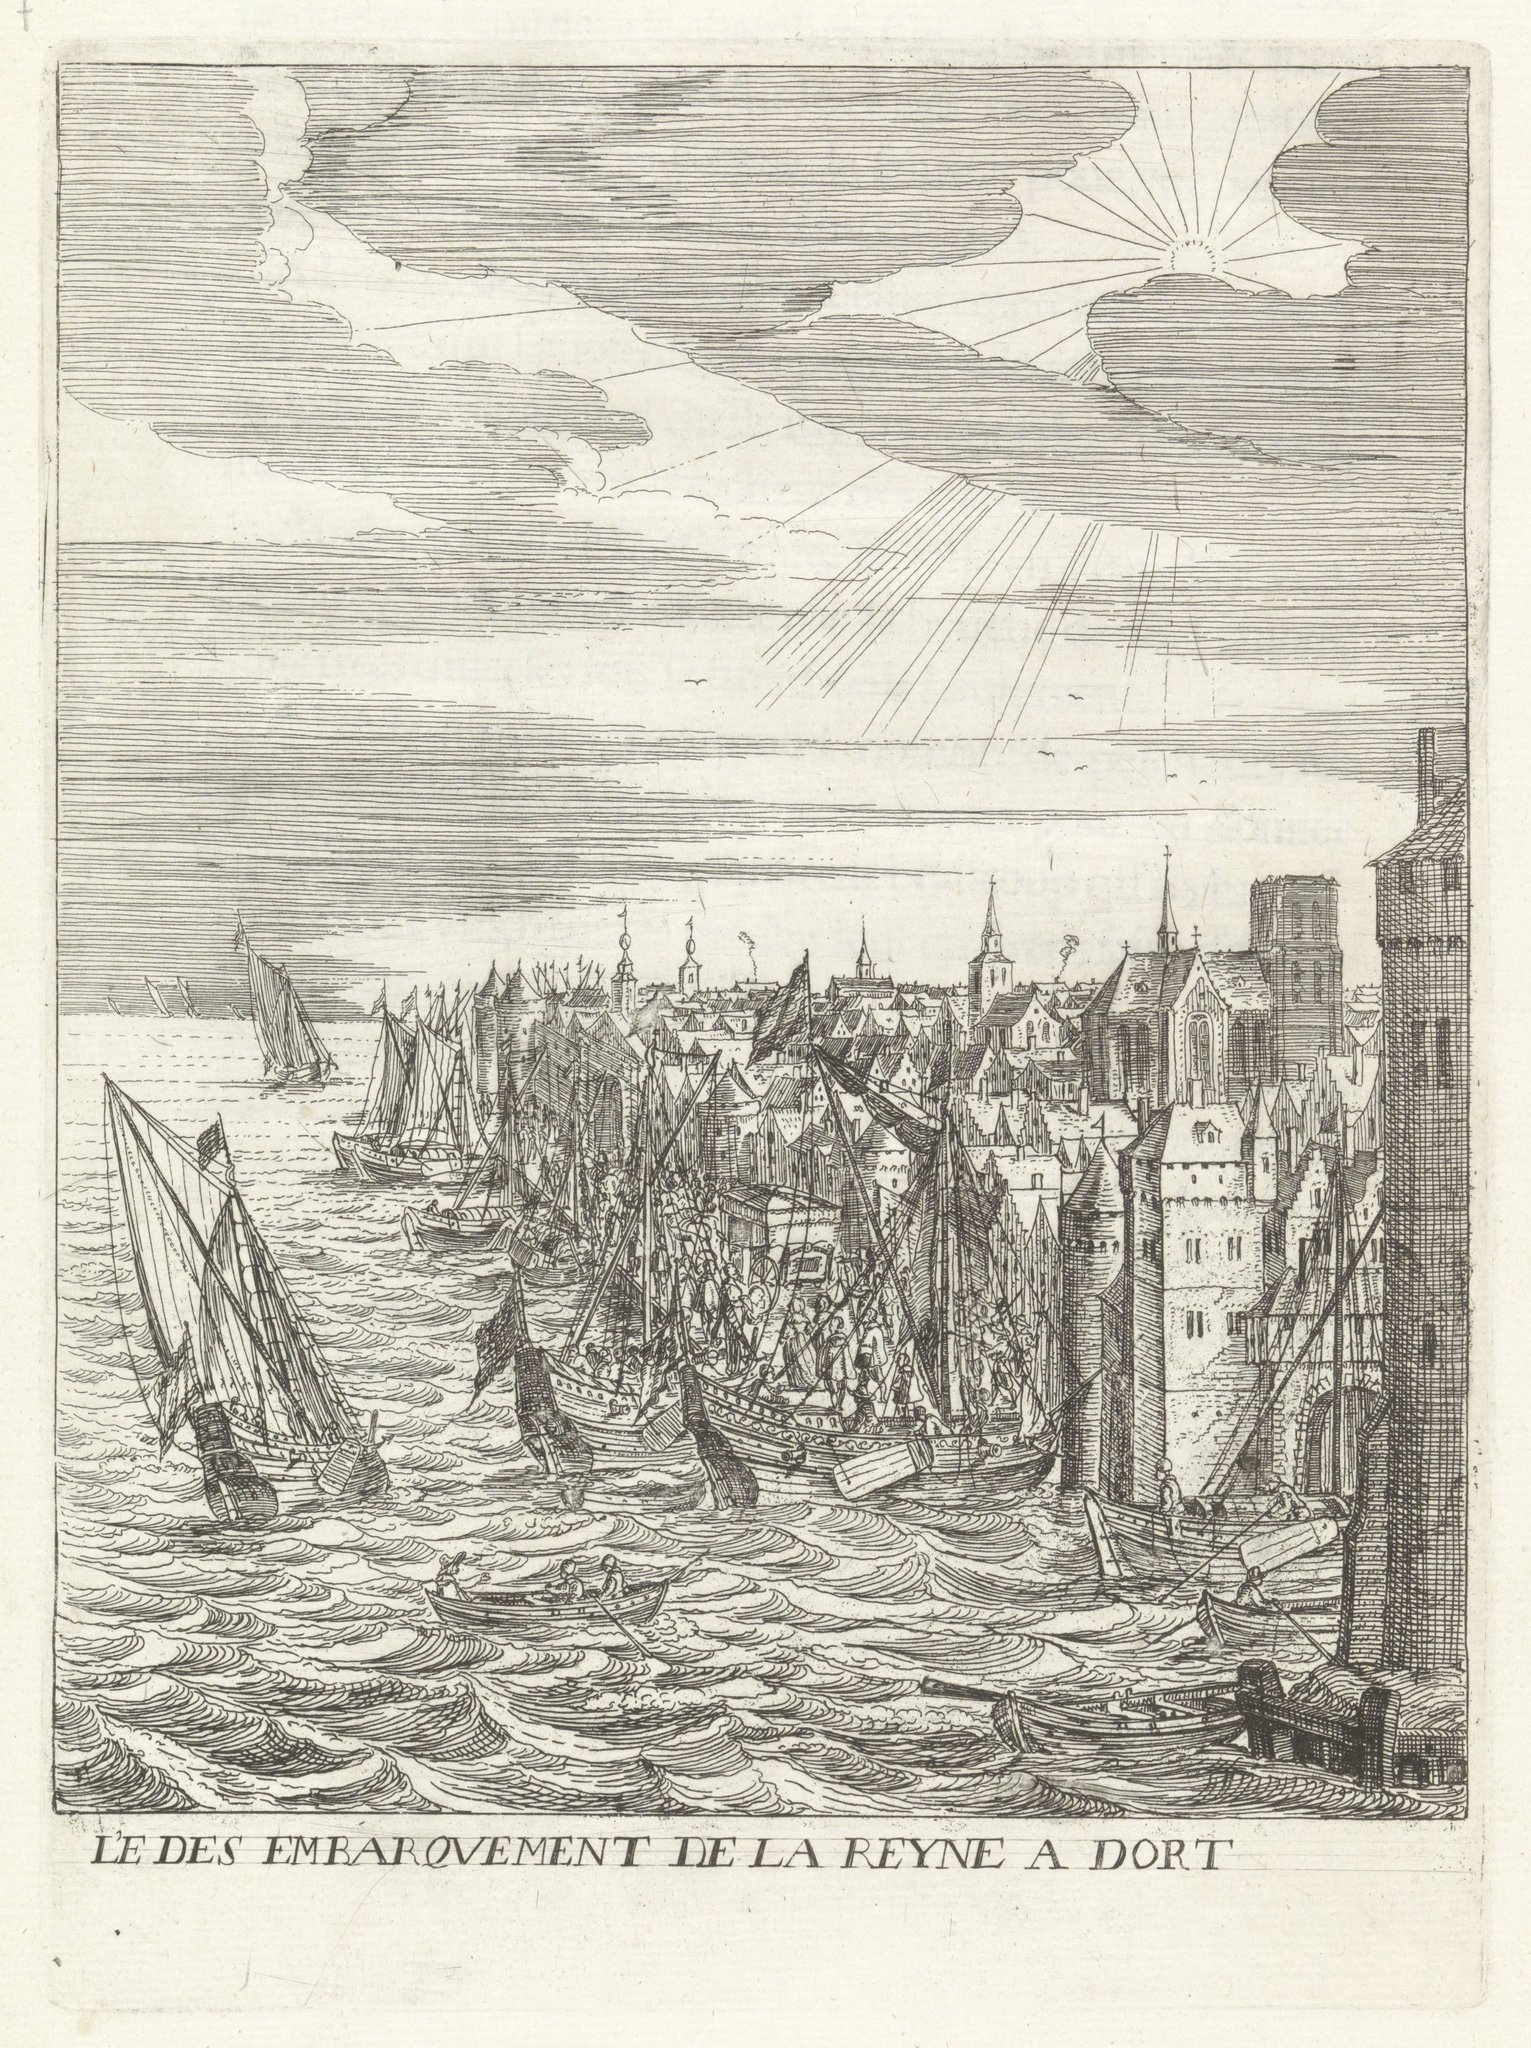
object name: print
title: Histoire de l'entree de la reyne mere du Roy tres-chrestien, dans les Provinces Unies des Pays-Bas.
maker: Anonymous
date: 1639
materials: paper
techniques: etching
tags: cologne, print maker, maria de' medici, triumphal entry and public reception, pageant, 'entrée solennelle', 'joyeuse entrée', dordrecht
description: Havengezicht van Dordrecht. Maria de' Medici arriveert per schip. Op de kade staan veel mensen. Ook haar koets staat klaar. De prent maakt deel uit van een boek over het bezoek van Maria de' Medici aan de Nederlanden.